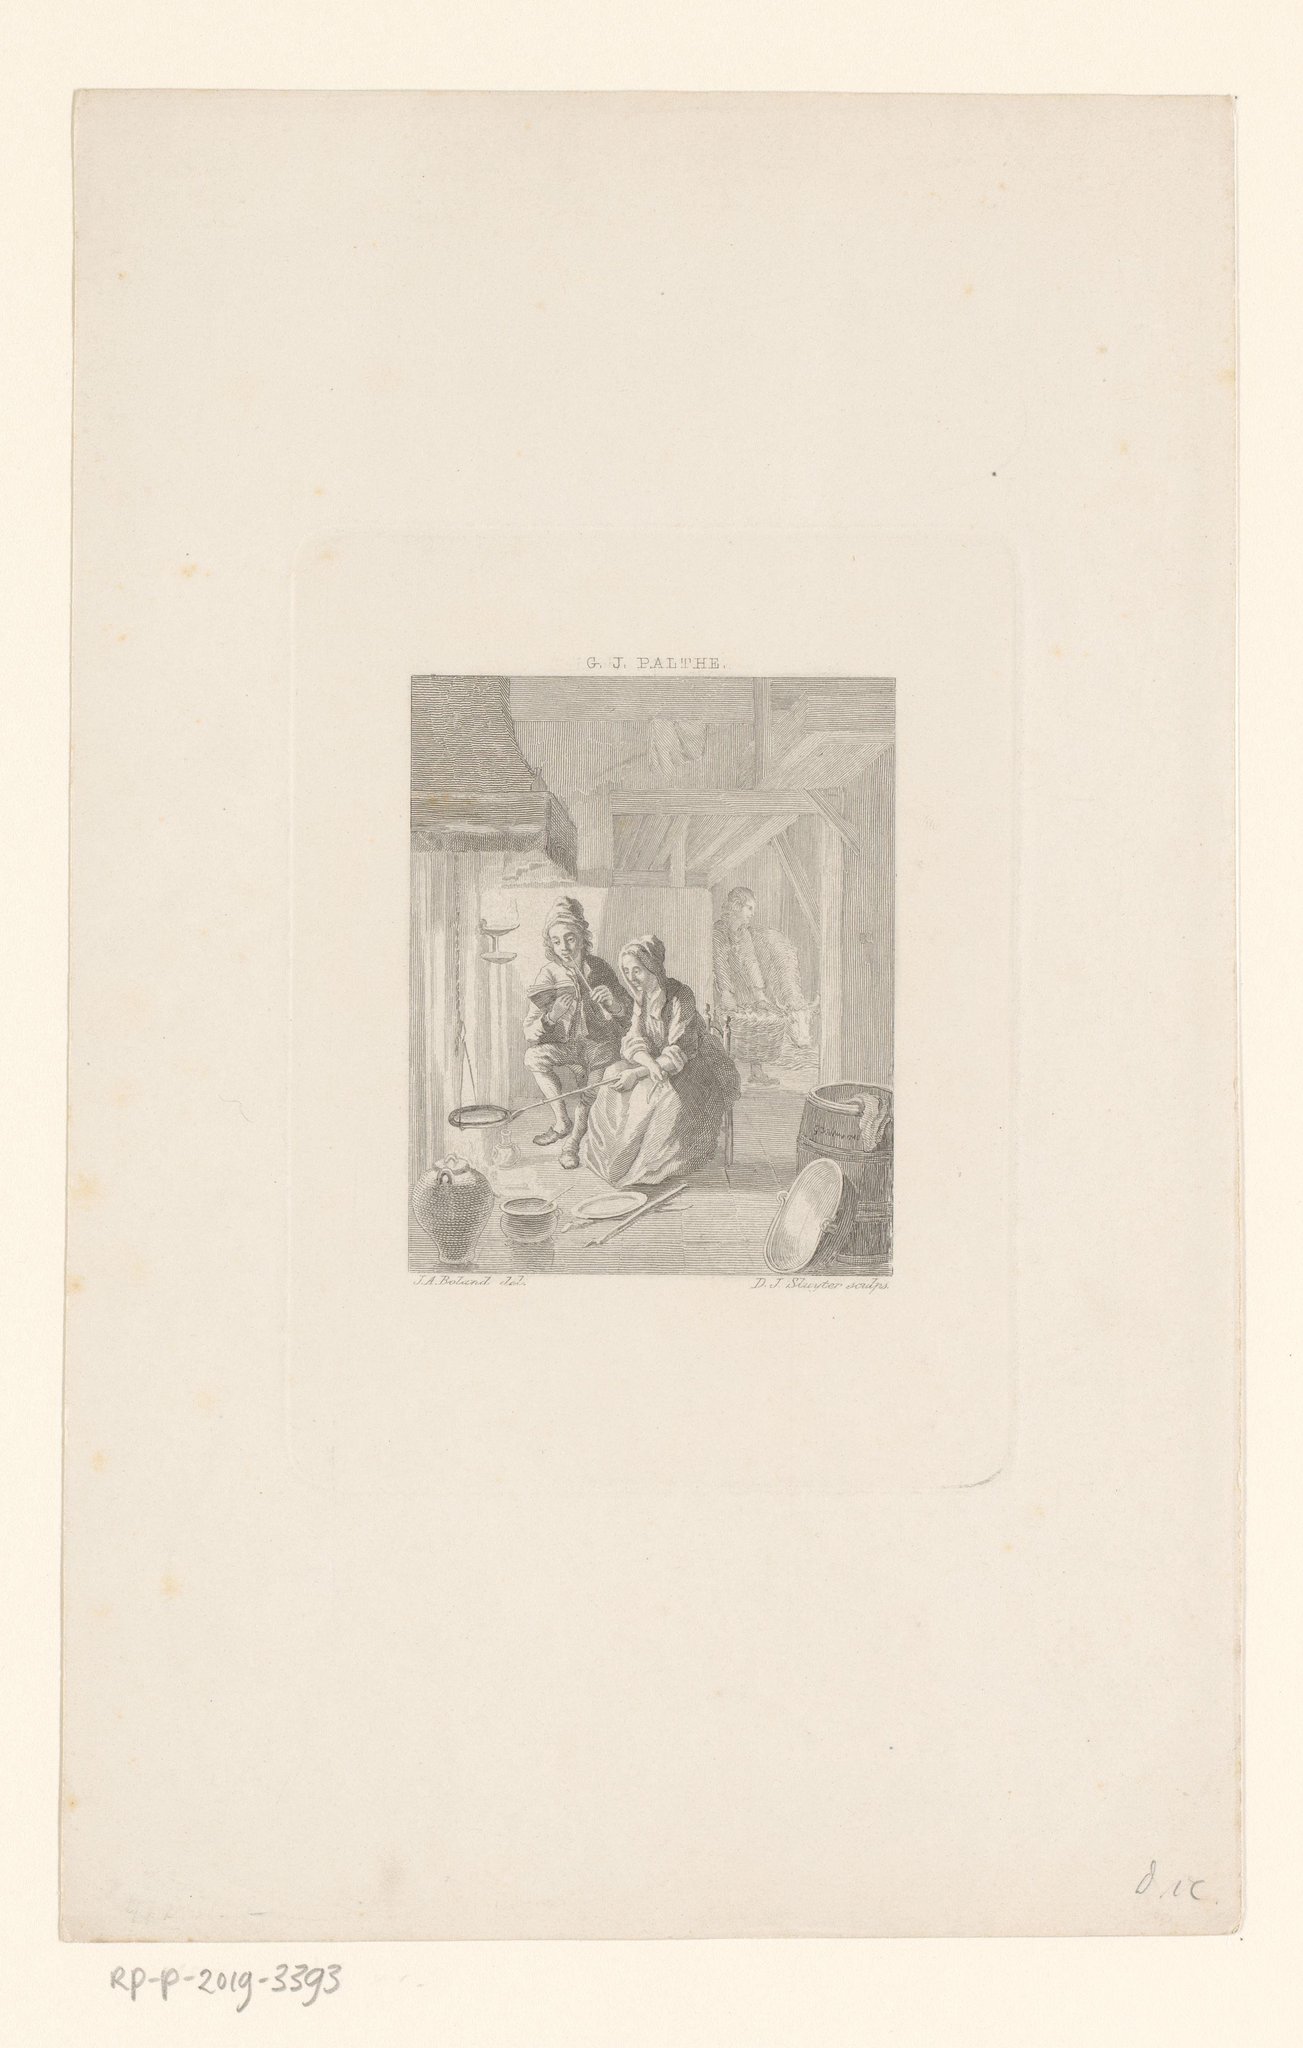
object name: print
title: Interieur met een man en vrouw bij een brandende haard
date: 1848-1886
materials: paper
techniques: etching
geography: amsterdam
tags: pancakes, reading, kitchen-interior, open fire, fire-place, stove (in kitchen)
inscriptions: collector's mark: Lugt 2228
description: Een man en een vrouw zitten bij een brandende haard. De man rookt een pijp en leest een boek. De vrouw bakt koeken in een pan die zij boven het vuur houdt. Op de achtergrond een doorkijkje naar de stal met een koe en een man die een mand draagt.